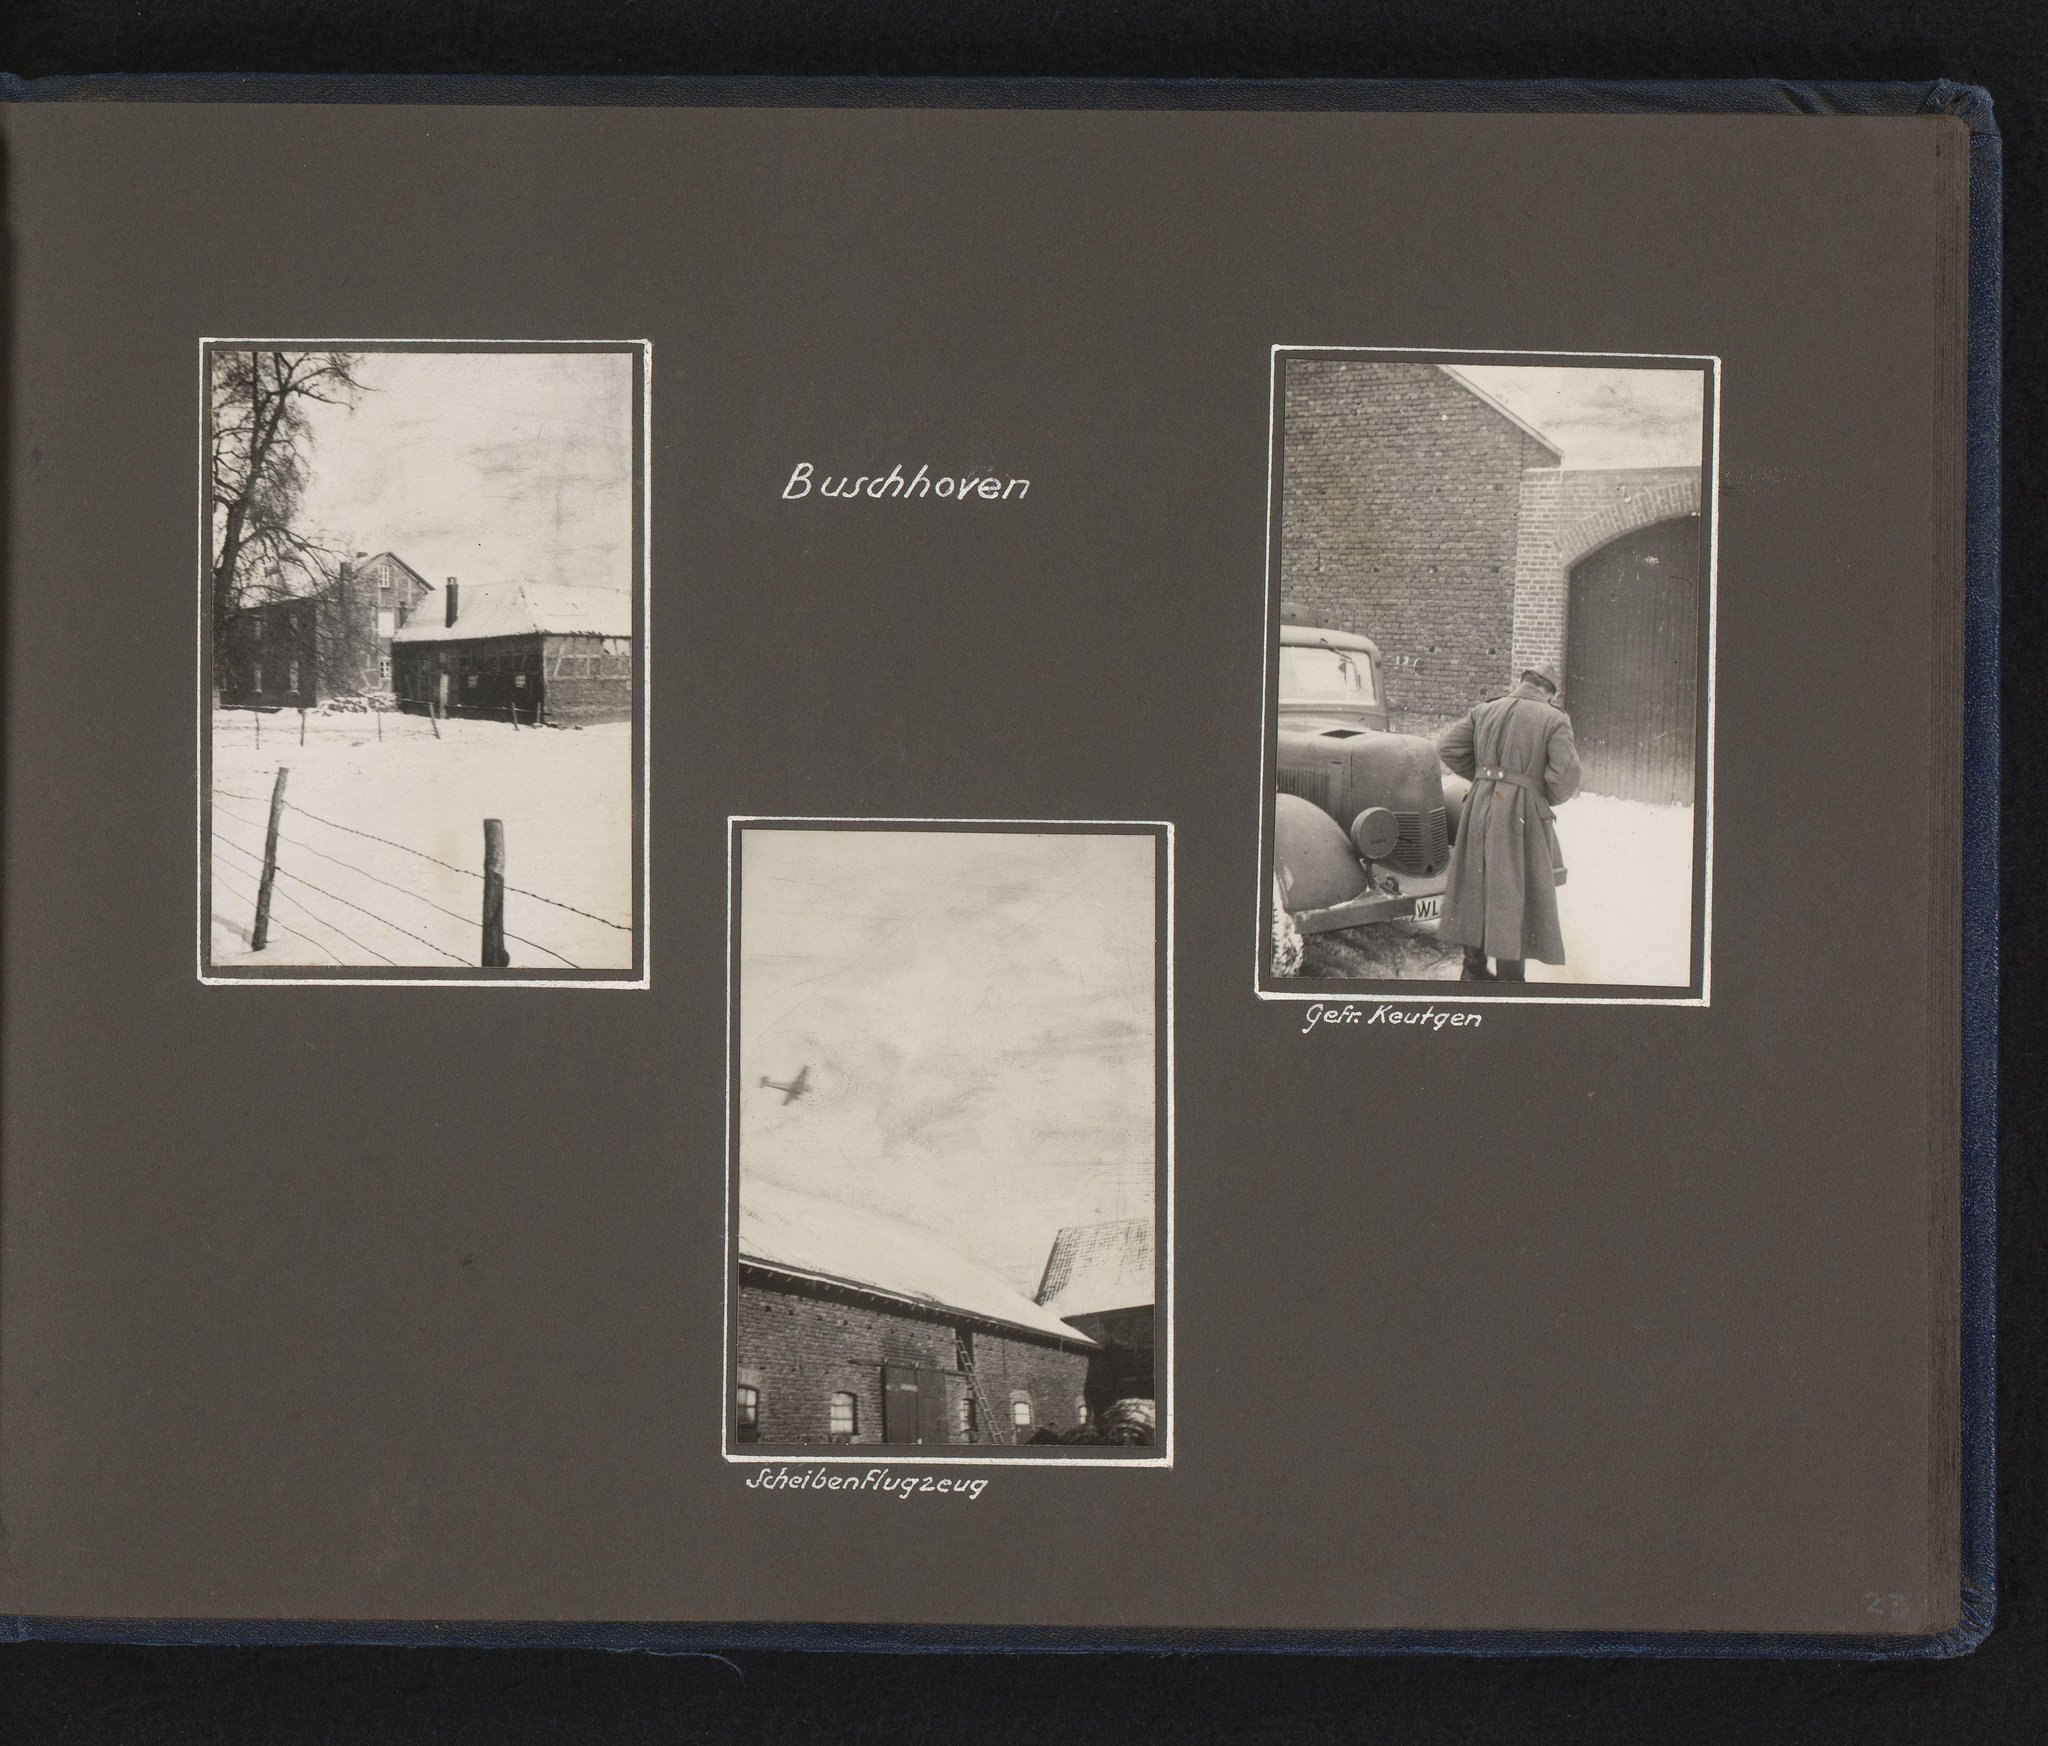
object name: photograph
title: Kwartier in Buschhoven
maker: Anonymous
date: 1939-1940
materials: paper, photographic support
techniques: gelatin silver print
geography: germany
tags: quartered in private houses, barracks, germany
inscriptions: inscription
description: Albumblad met drie foto's van de militaire inkwartiering in een boerderij in Buschhoven, winter 1939-1940. Onderdeel van een Duits militair album Tweede Wereldoorlog 1939-1940.